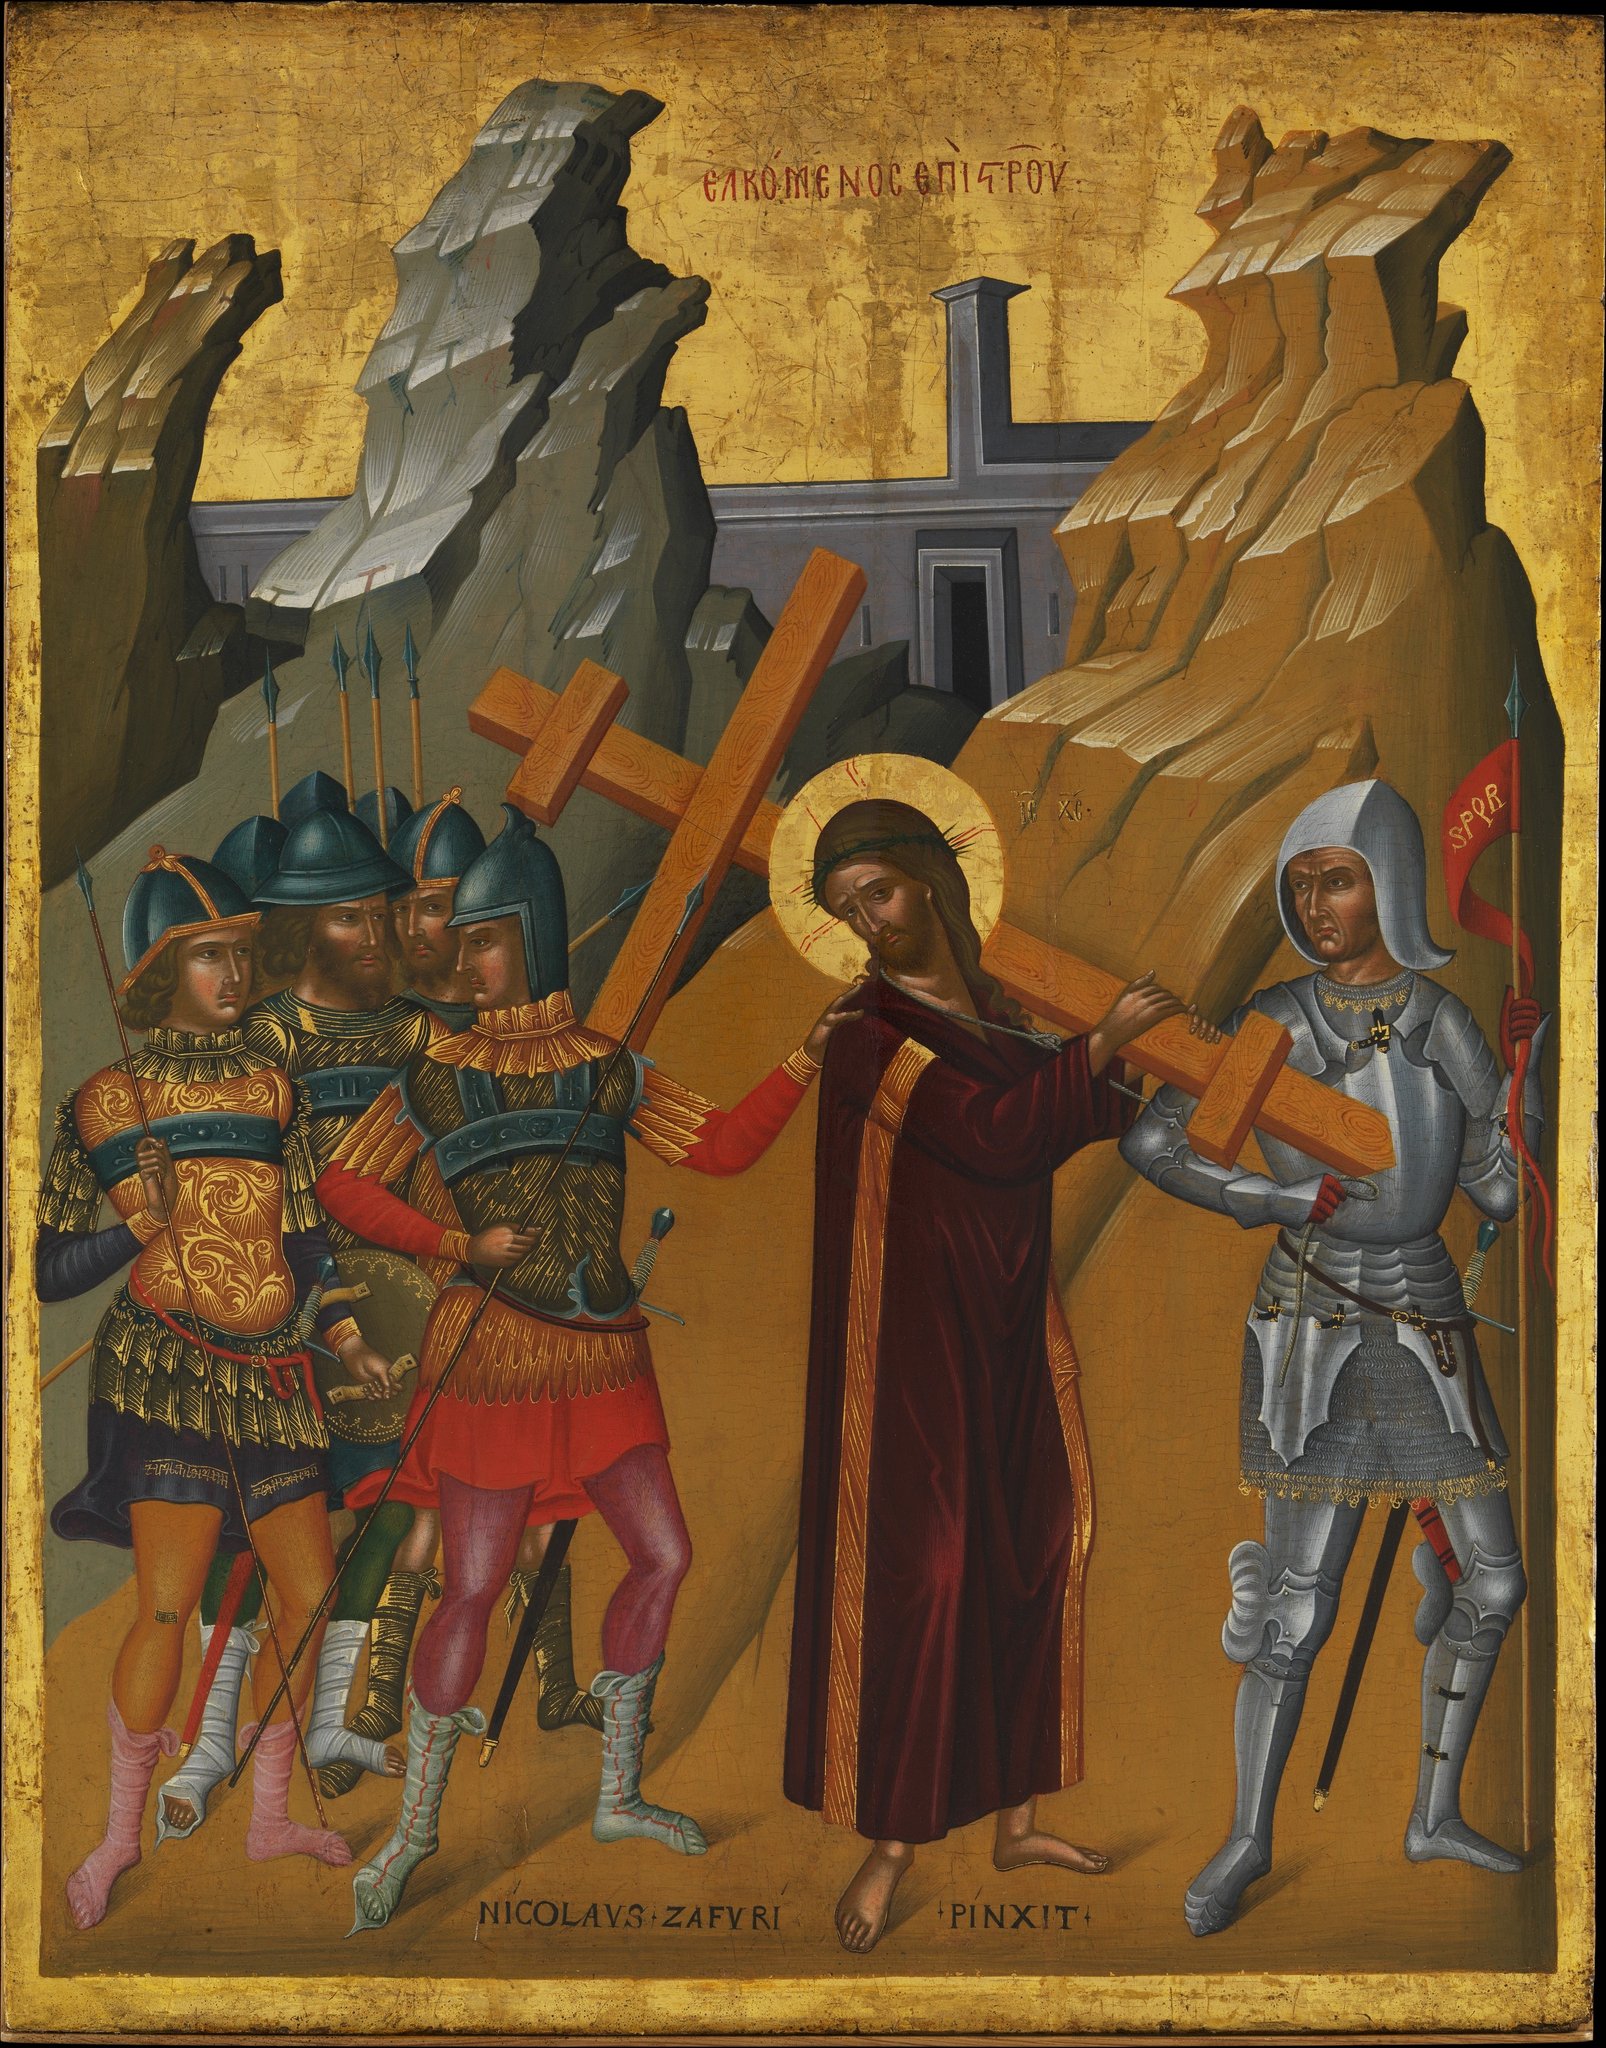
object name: painting, icon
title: Christ Bearing the Cross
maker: nicolaos tzafouris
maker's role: artist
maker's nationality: greek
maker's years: 1455-1501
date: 1489-1500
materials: gold leaf, oil, paint, wood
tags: soldiers,men,cross,jesus,bearing the cross